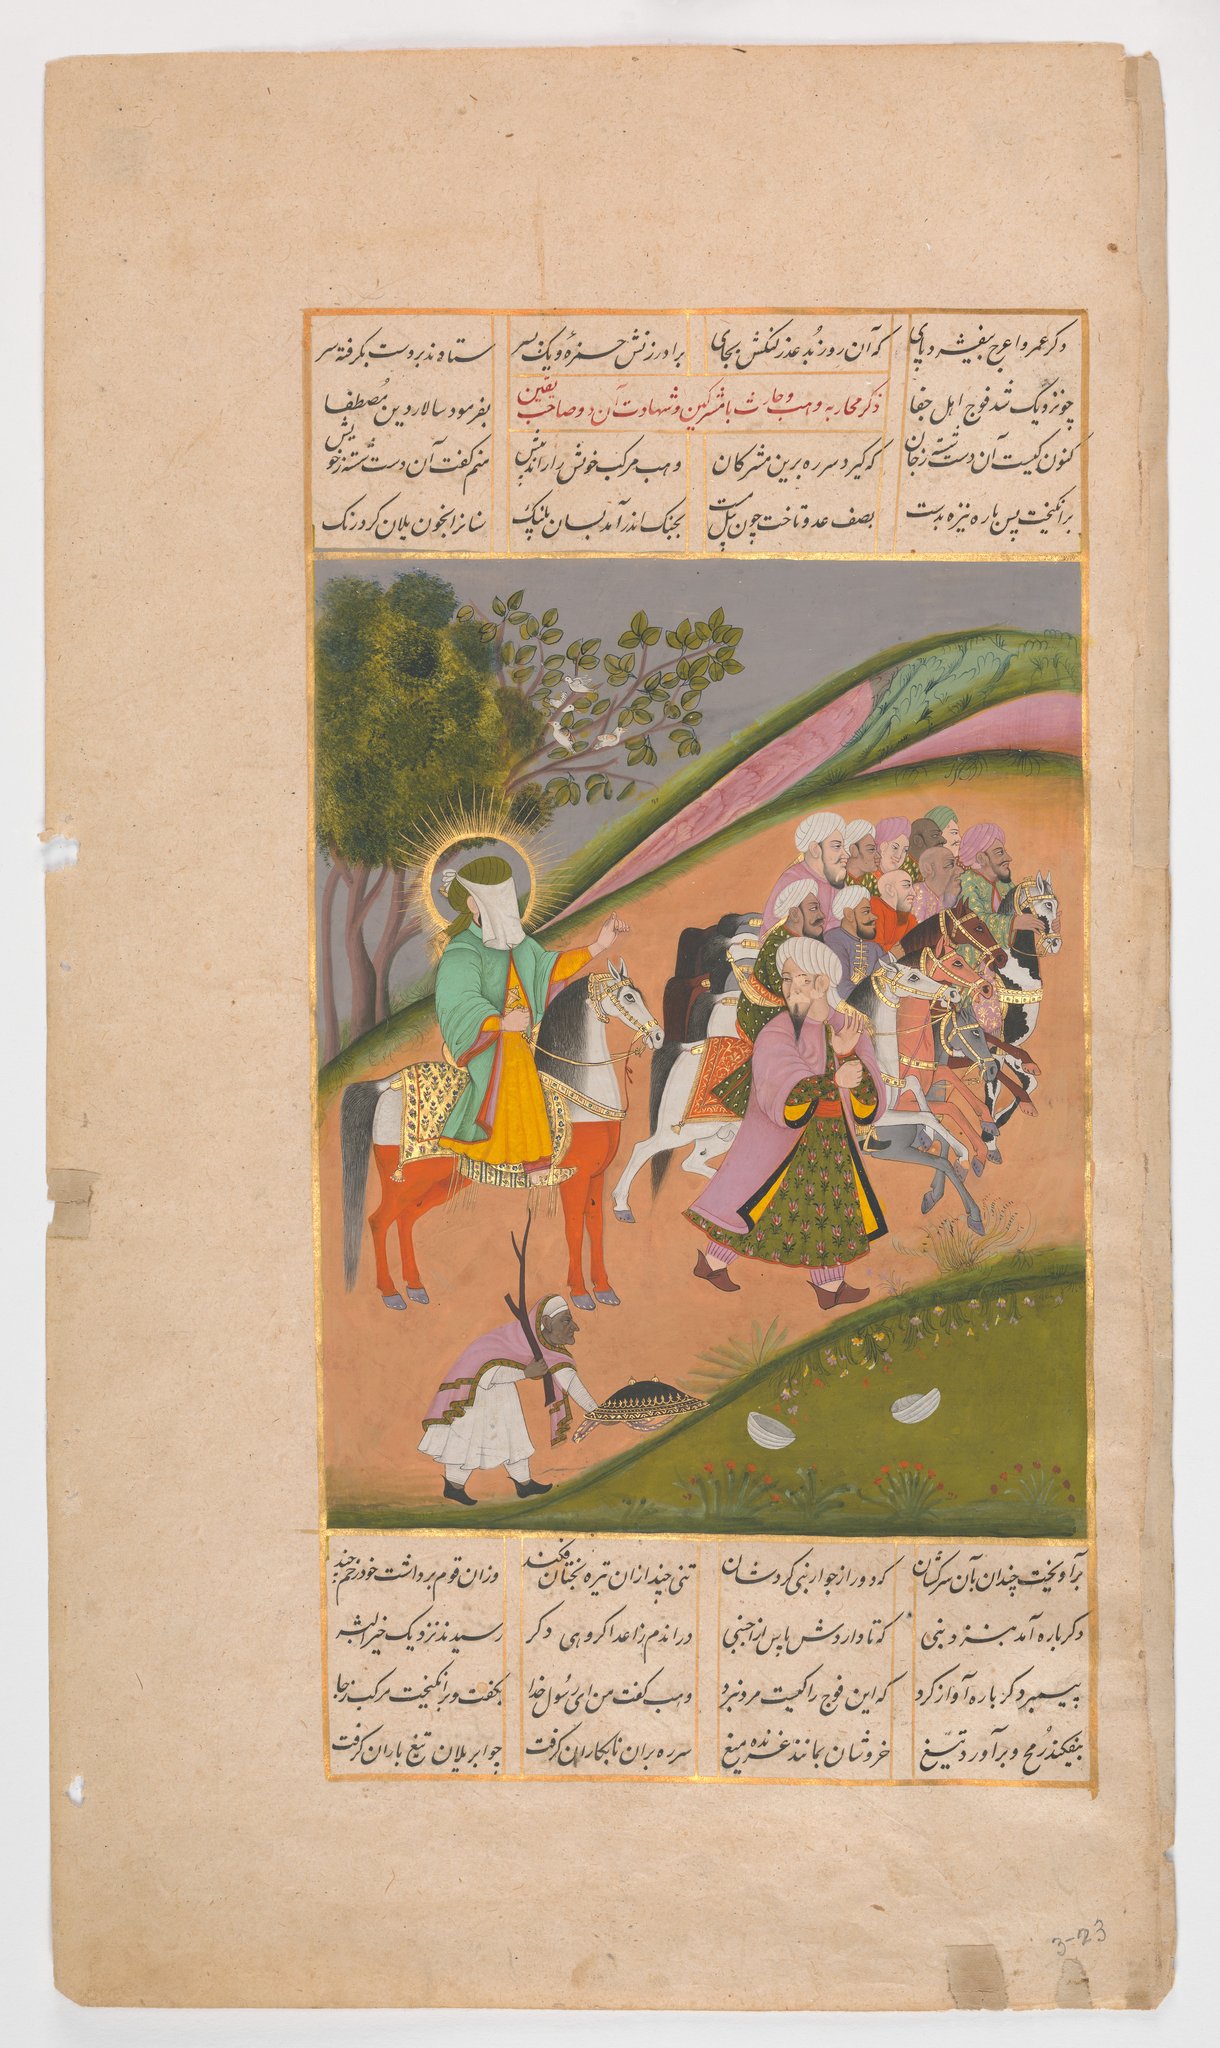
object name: folio from an illustrated manuscript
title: "Muhammad and His Followers Going to Battle," Folio from a Hamla-yi Haidari (Attack of the Lion)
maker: muhammad rafi khan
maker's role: author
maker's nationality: indian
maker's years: 1611-1711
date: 1820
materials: gold, ink, paper, watercolor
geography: india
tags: men,horses